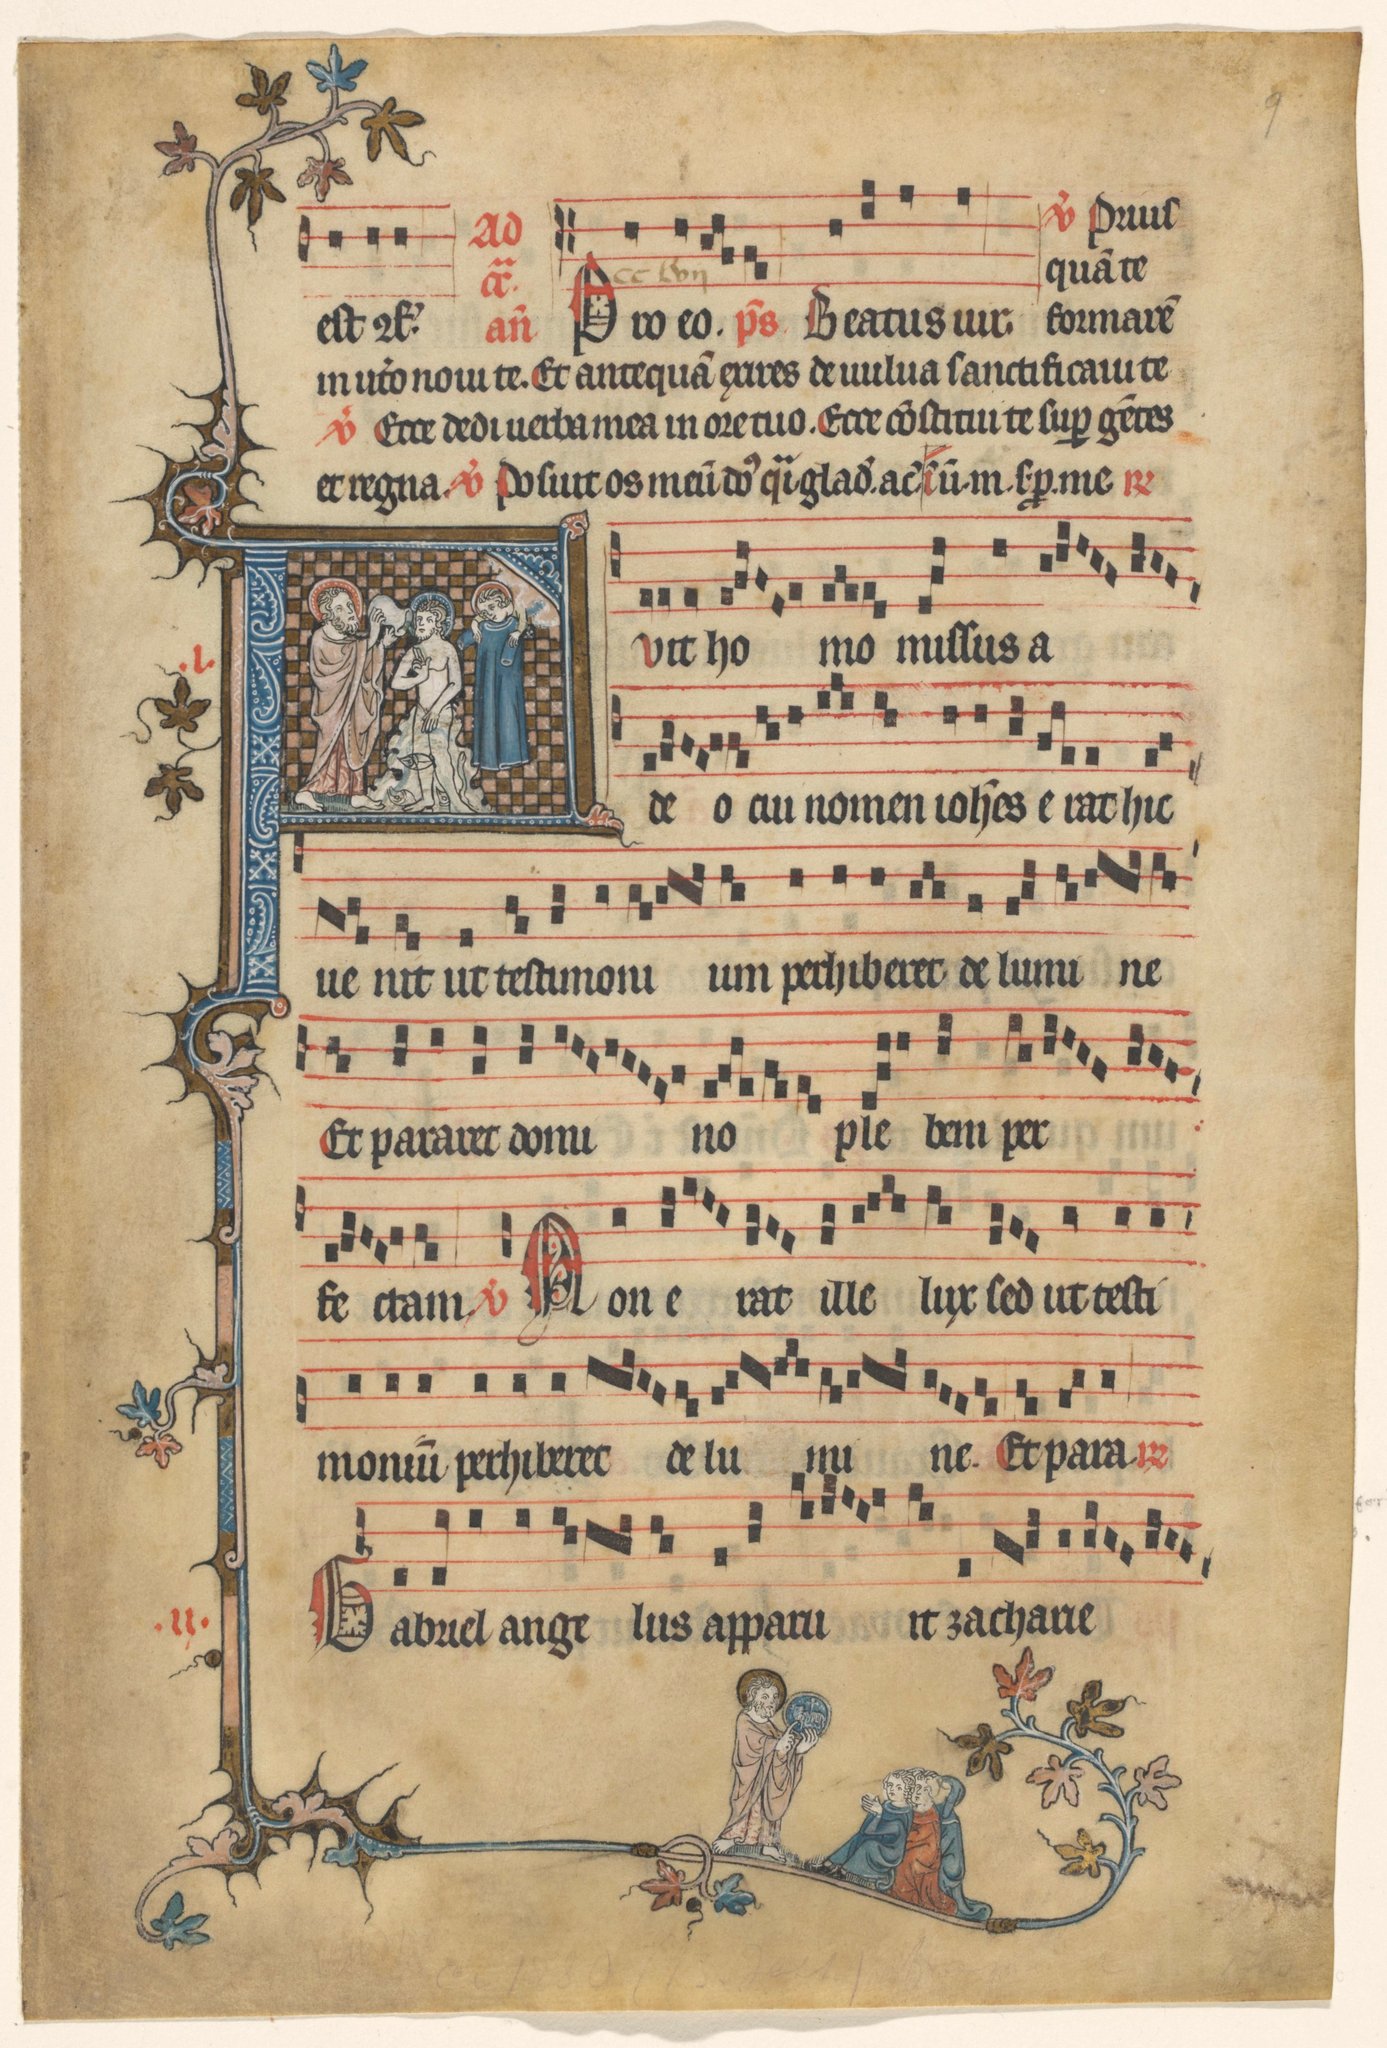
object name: miniature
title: Fragment van een antiphonarium: initiaal F met doop van Christus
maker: Anonymous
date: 1390-1410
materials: paint, gold leaf, ink, parchment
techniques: brush, pen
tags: baptism of christ in the river jordan: john the baptist pouring out water on christ's head: the holy ghost descends, manuscript of musical score, historiated initial